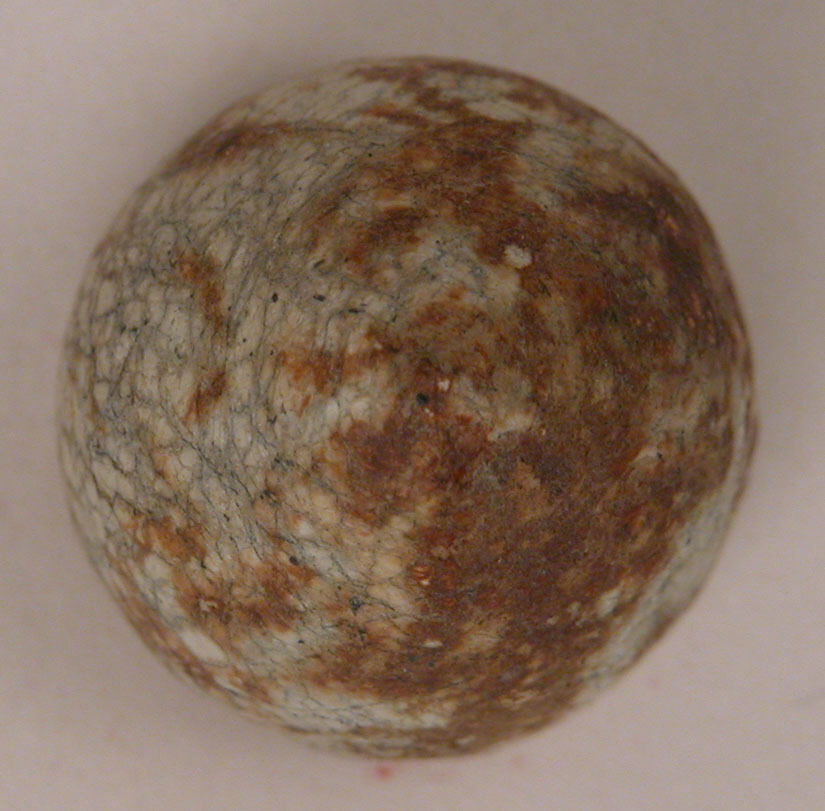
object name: gaming or chess piece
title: Gaming or Chess Piece, Possibly a Pawn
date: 701-1100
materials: stone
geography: western islamic lands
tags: chess